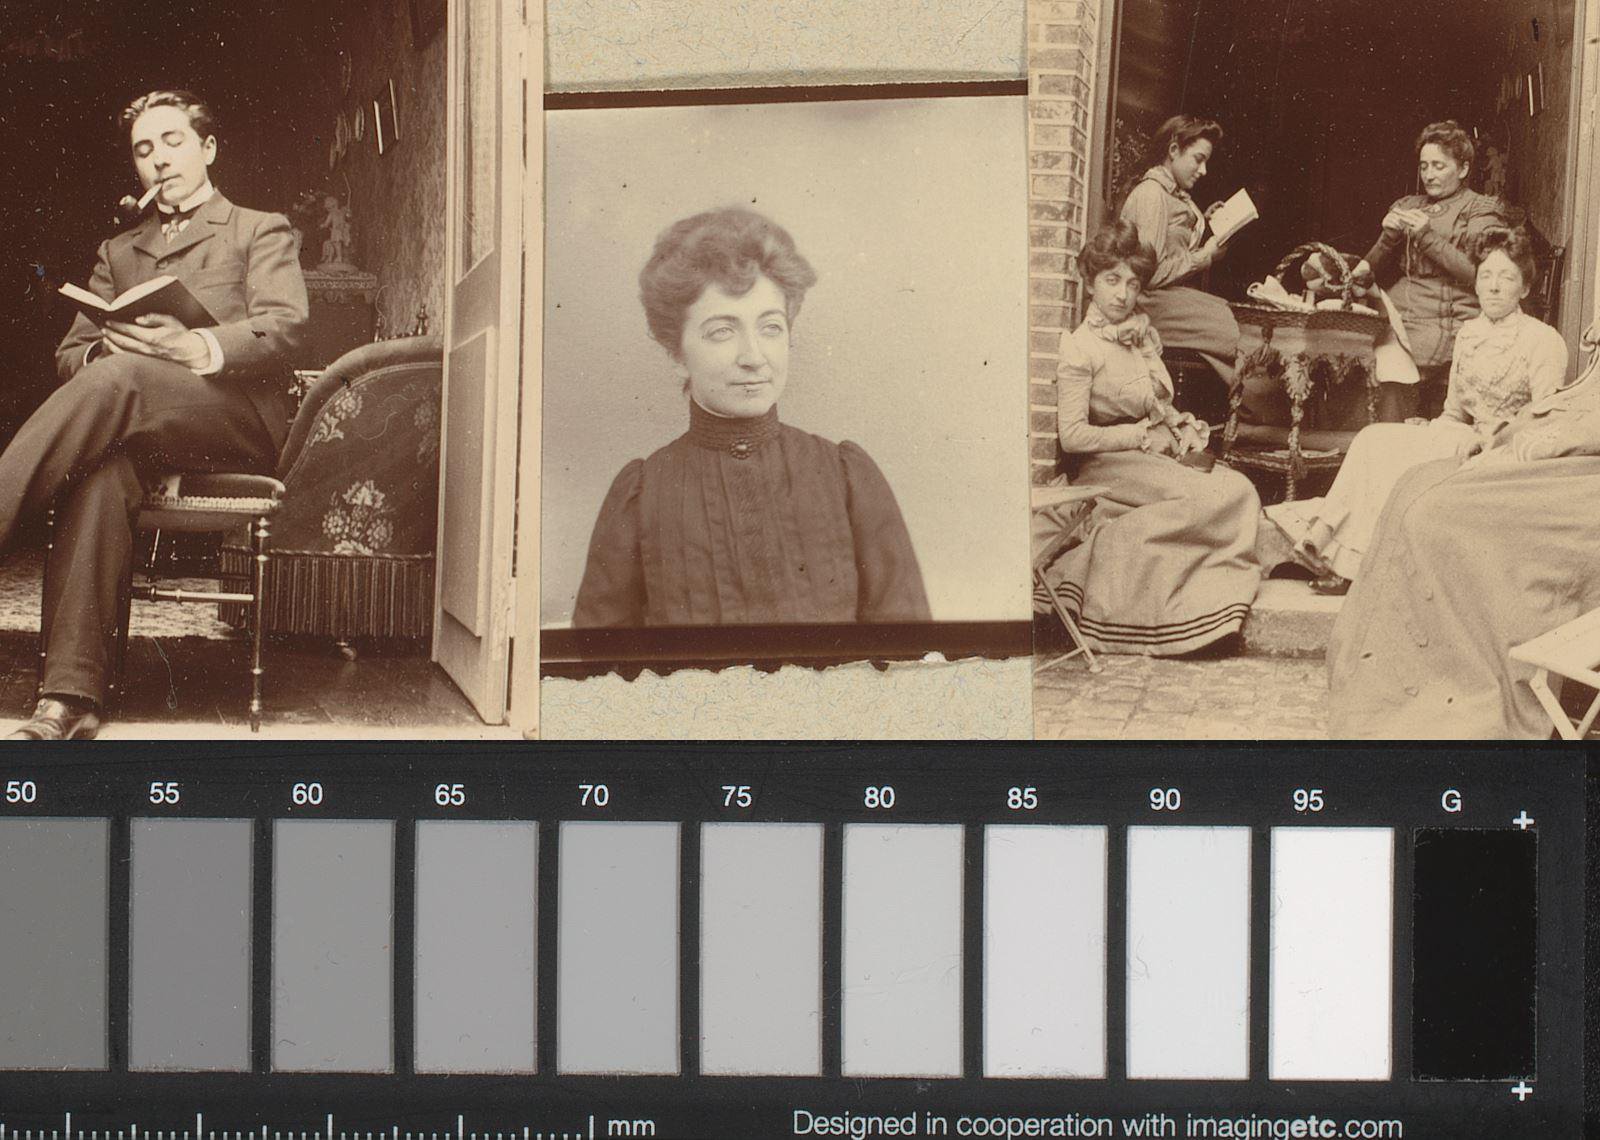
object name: photograph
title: Portret van een vrouw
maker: Anonymous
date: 1897-1900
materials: paper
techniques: gelatin silver print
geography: france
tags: adult woman, historical persons, france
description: Over de foto is een ander negatief afgedrukt van een voorstelling van bomen.